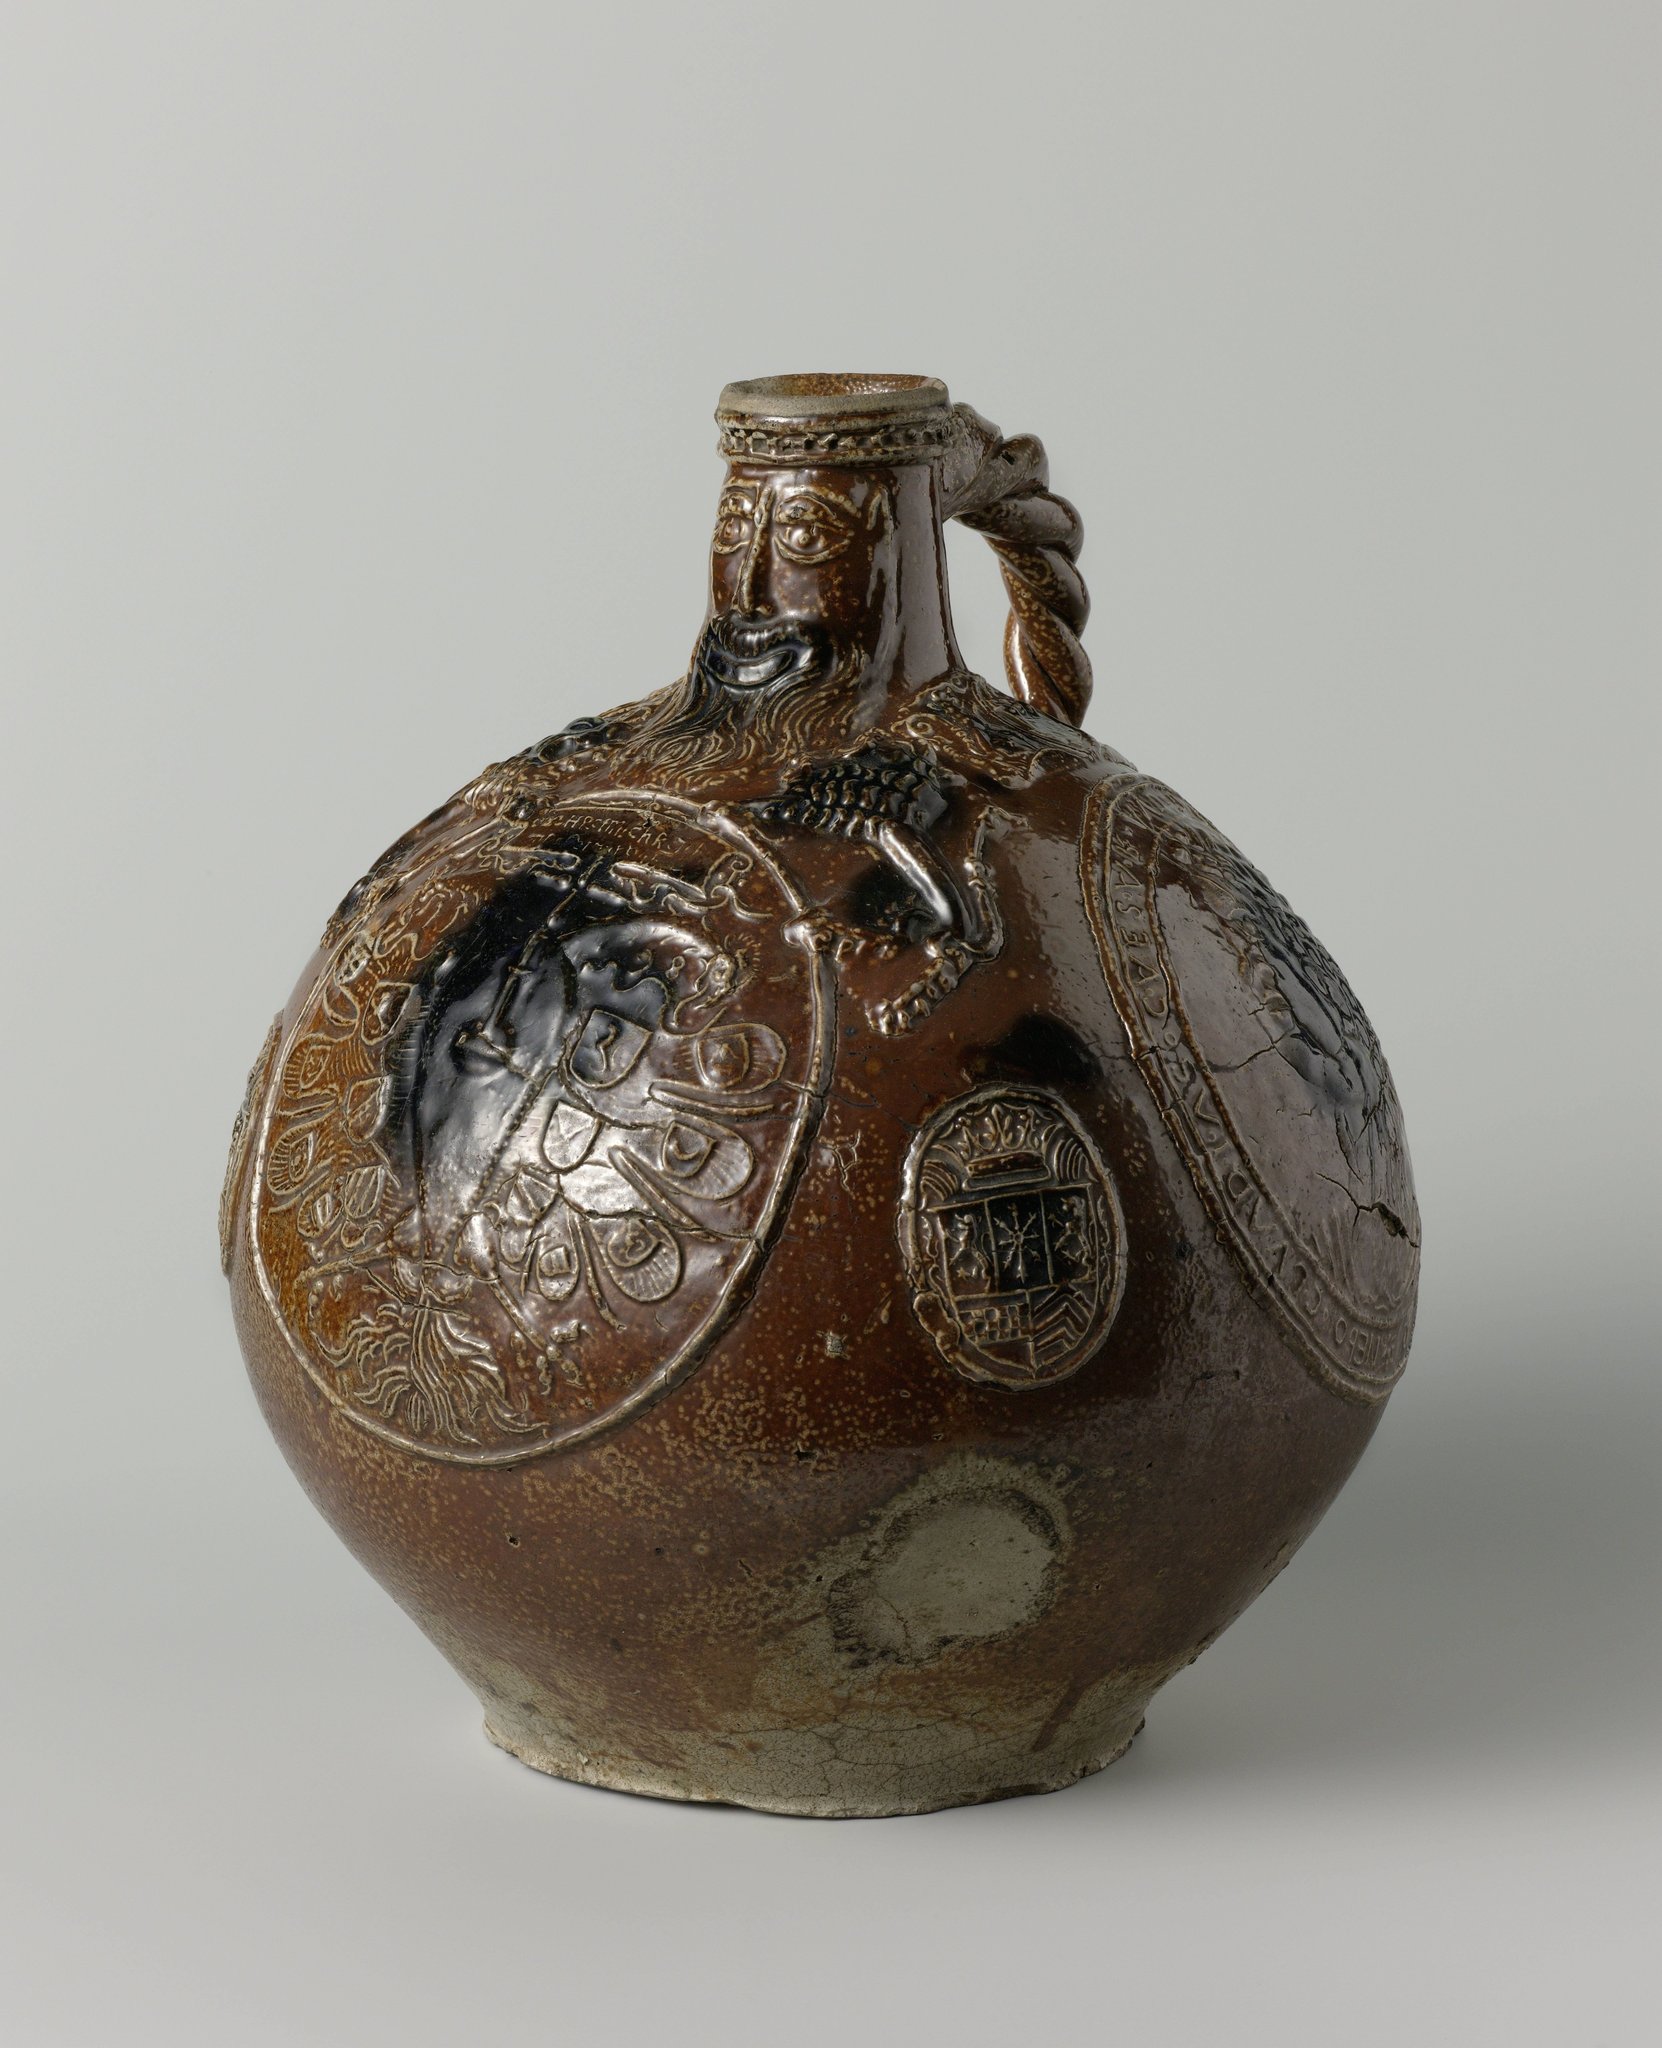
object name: jug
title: Bartmann (bearded-man) jug with three medallions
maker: Anonymous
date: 1598-1610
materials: cobalt, engobe, glaze, stoneware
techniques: firing, forming, relief, turning, vitrification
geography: frechen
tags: double-headed eagle, beard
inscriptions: inscription: ‘CEASAR AVG PM TR IMP P [...] CLAUDIU[...]’, date: ‘1598’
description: Kruik (baardmankruik) van steengoed op standvlak met een bolvormig lichaam en smalle, korte nek. Het getordeerde, C-vormige oor is bevestigd aan de nek en de schouder. Profielen op de nek. Bedekt met een bruine engobe en kobaltblauw. Op de buik driemaal een groot, gedrukt en opgelegd medaillon in reliëf. Het middelste medaillon toont een wapen met een dubbele adelaar, de datum '1598' en een cartouche met een onleesbaar opschrift. Het wapen wordt gedragen door leeuwen. Aan weerszijden hiervan een medaillon met een portret van een keizer met elk het randschrift 'CEASAR AVG PM TR IMP P [...] CLAUDIU[...]'. Tussen de grote medaillons twee kleine met een wapen. Over de schouders een rechthoekig vak met een wapen geflankeerd door leeuwen en krulwerk. Op de nek, doorlopend op de schouder, een baardman. Frechen.